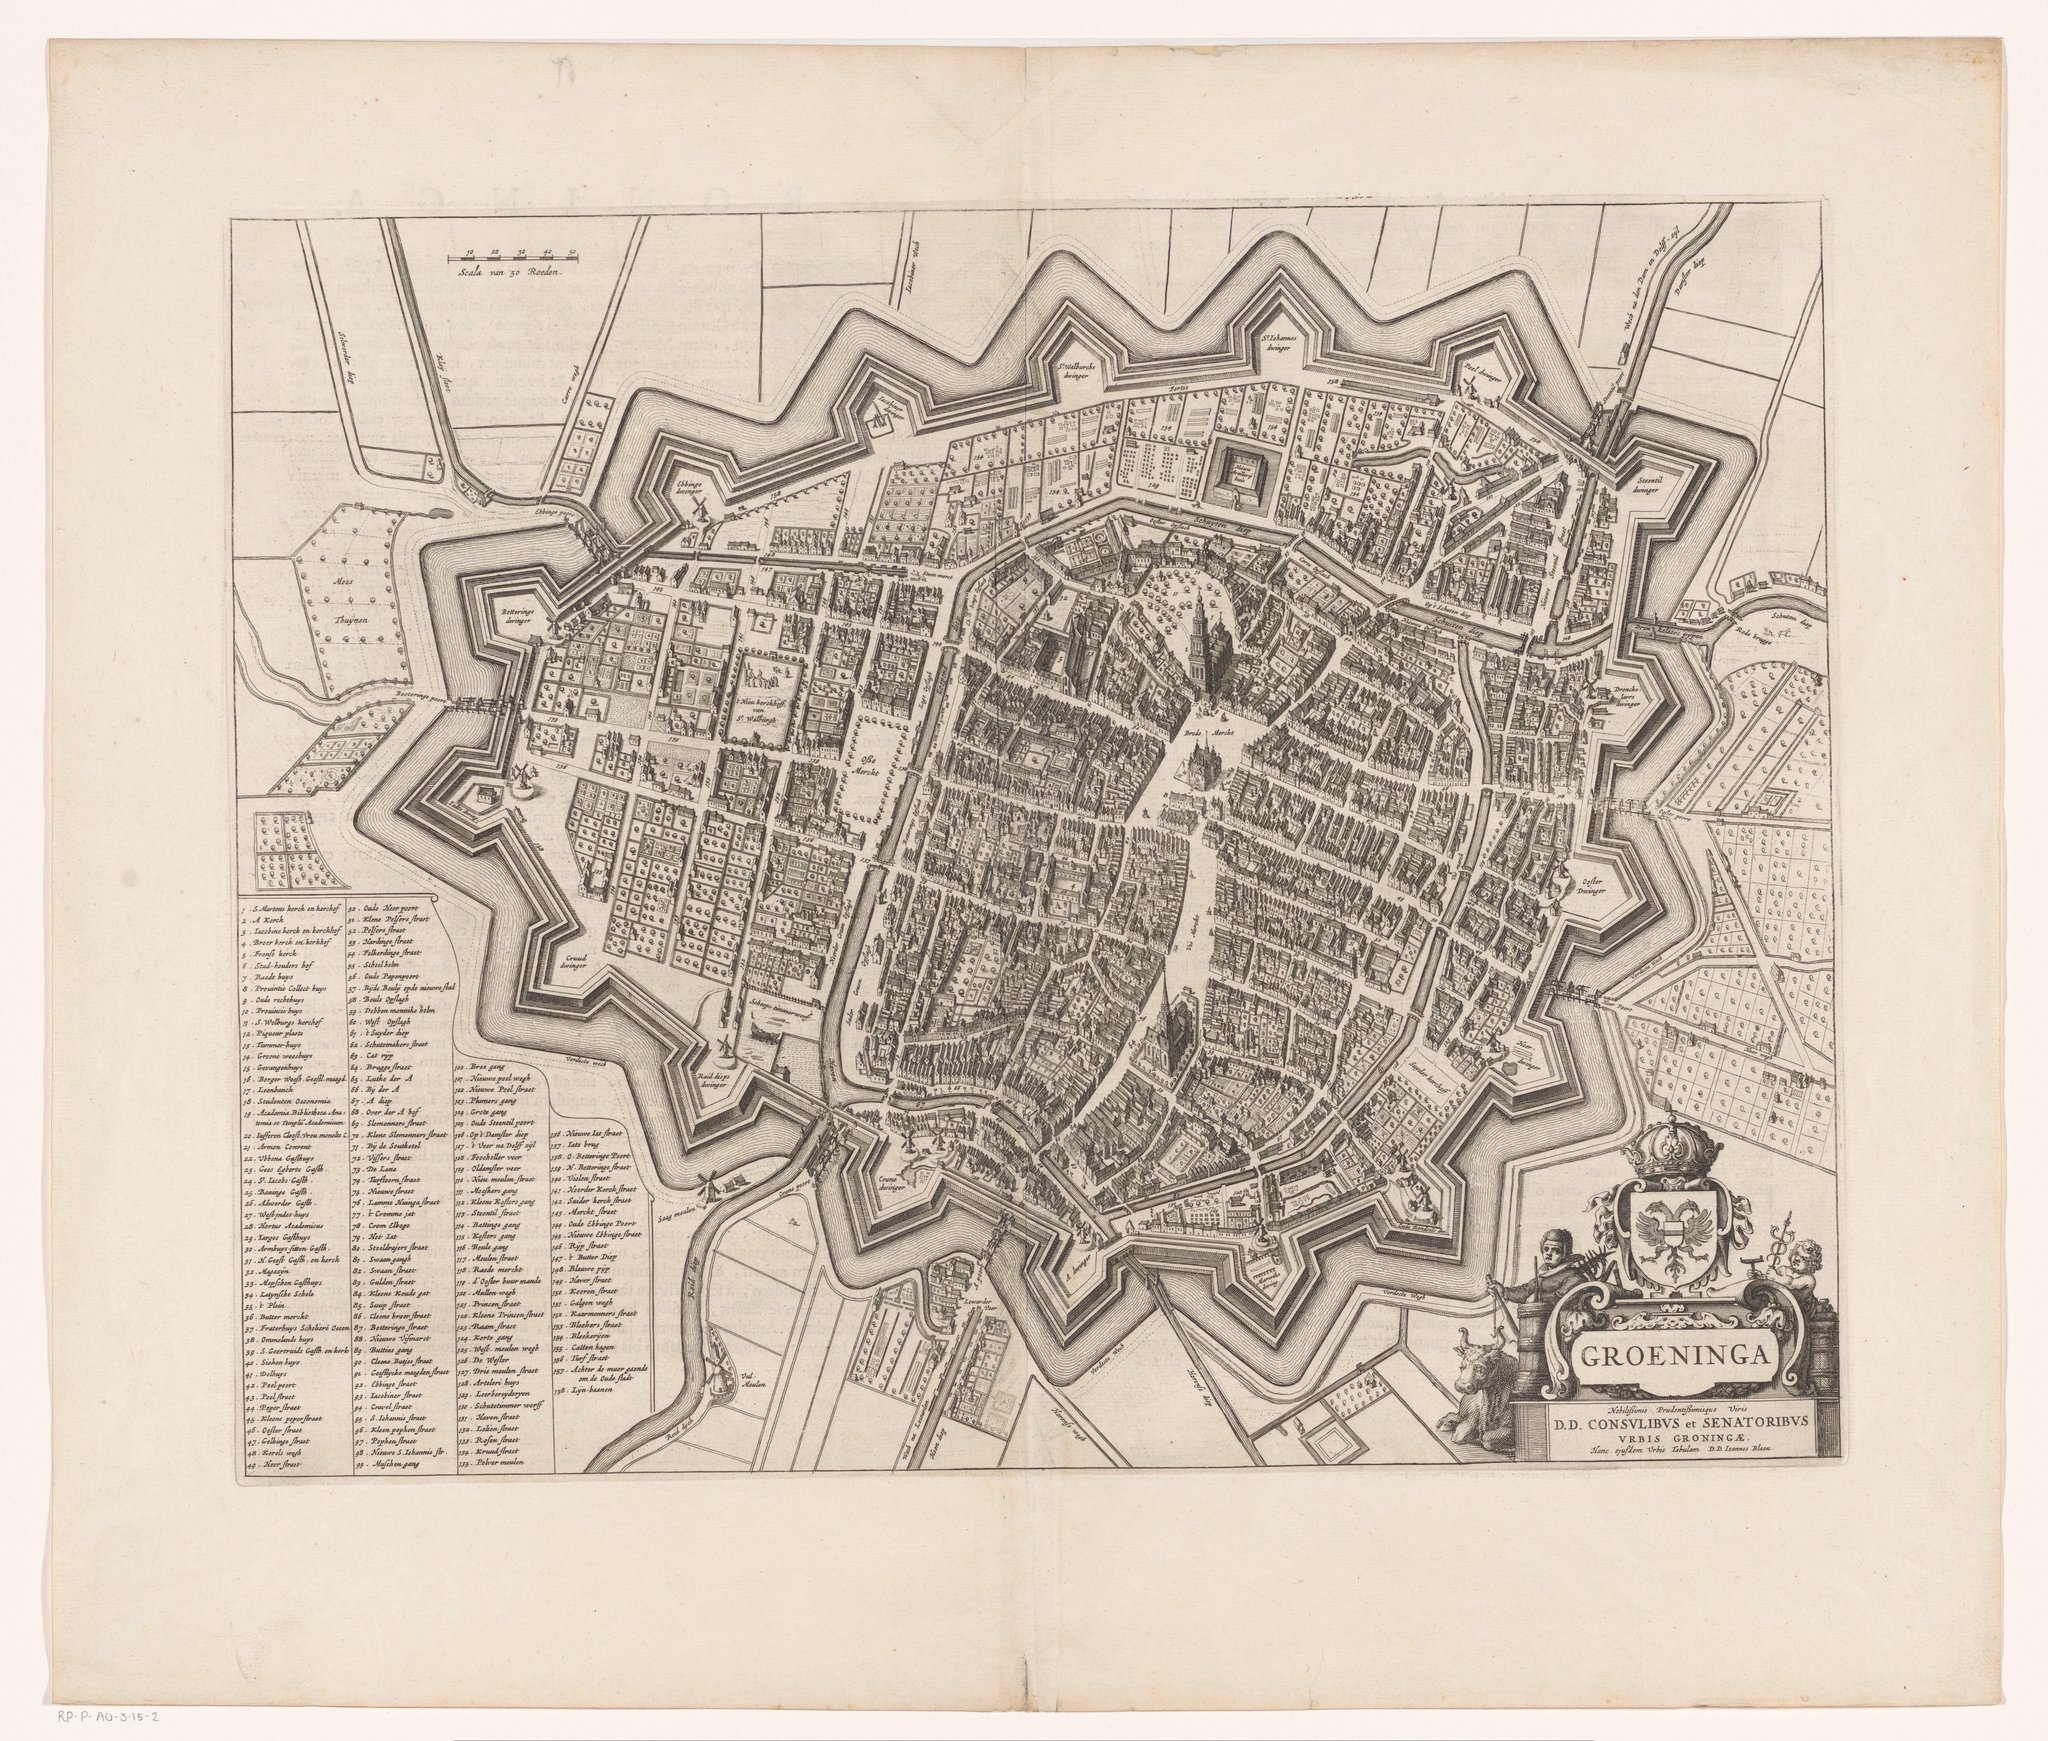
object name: print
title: Groeninga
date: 1652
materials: paper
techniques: engraving, etching, letterpress printing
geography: groningen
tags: coat of arms (as symbol of the state, etc.), maps of cities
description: Plattegrond in vogelvluchtperspectief. Linksboven schaalstok: Scala van 50 roeden. Linksonder legenda. Rechtsonder cartouche met het wapen van de stad Groningen, titel en opdracht. Op verso Latijnse tekst.